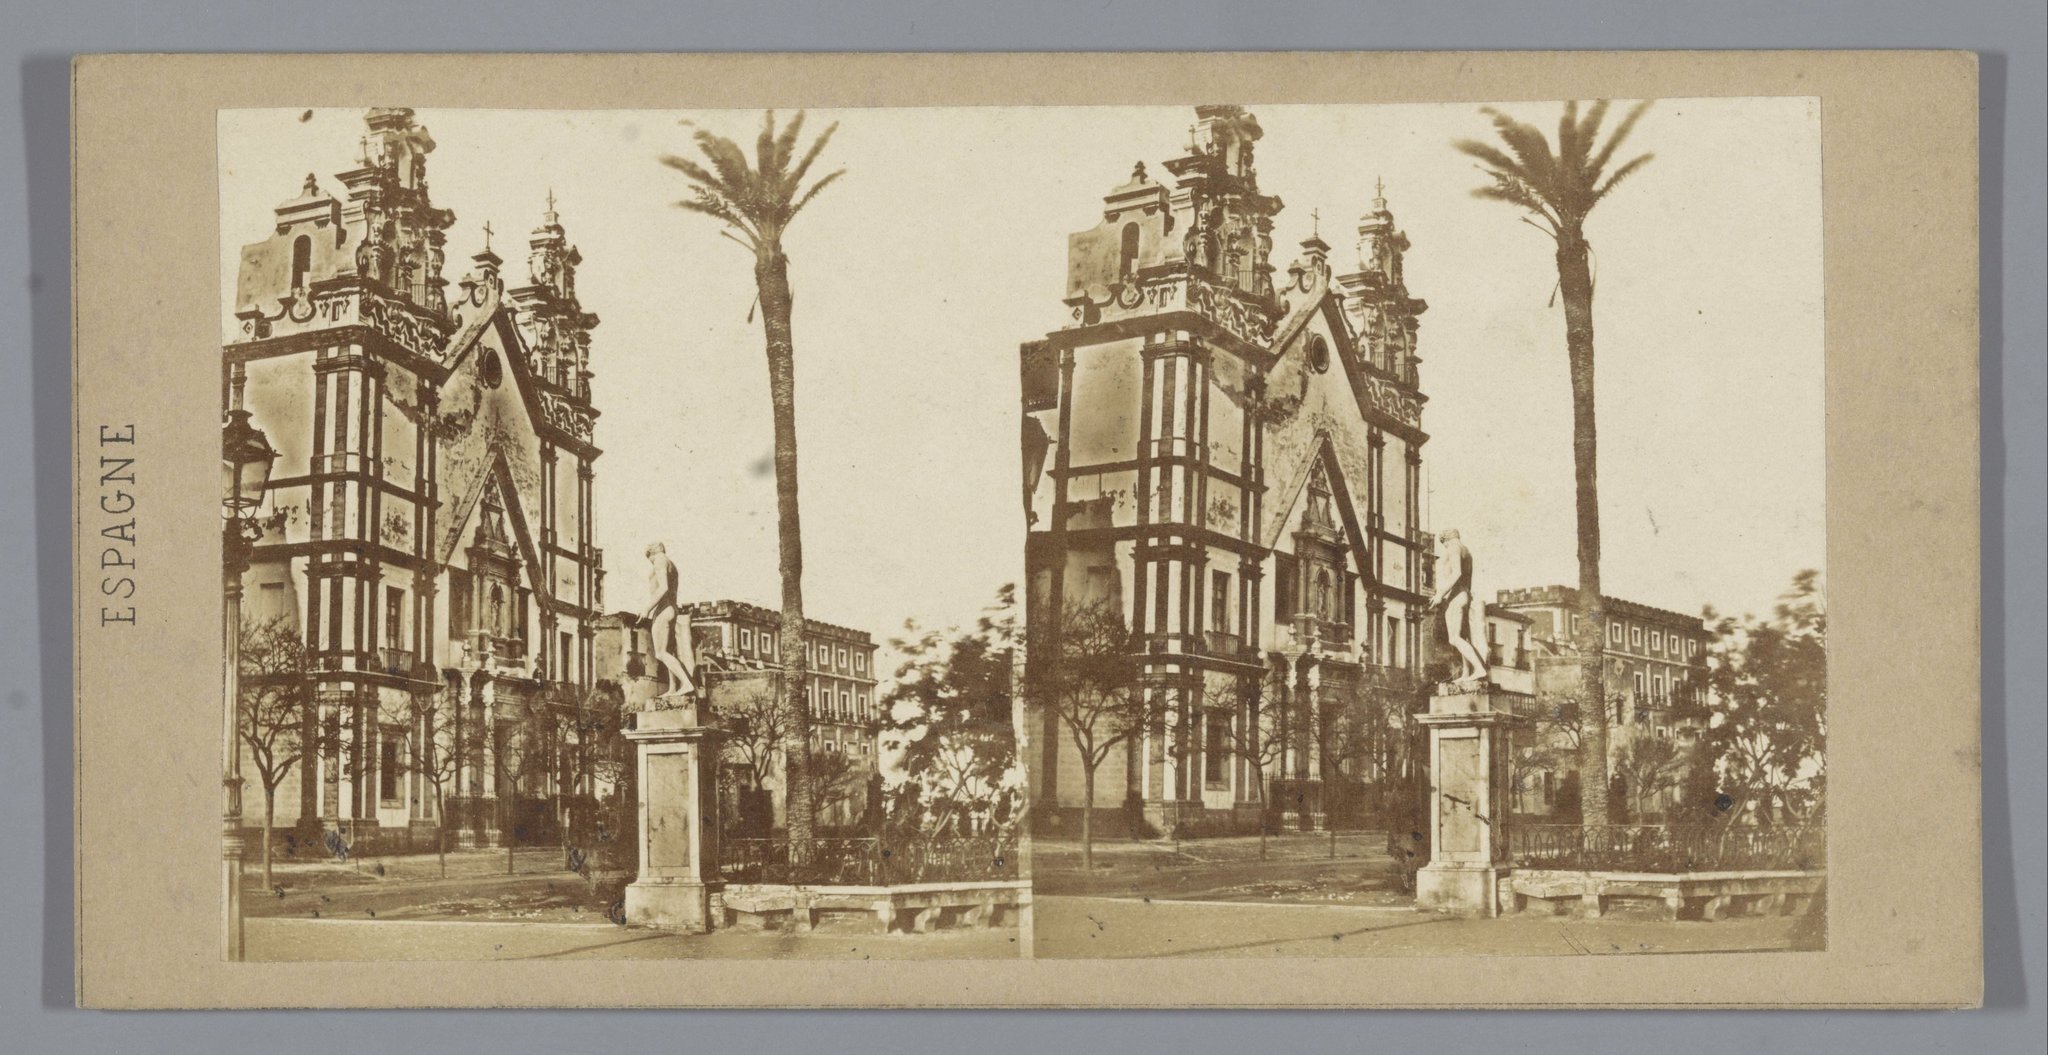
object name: stereograph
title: Alameda de Apodaca, à Cadix.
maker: Anonymous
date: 1850-1880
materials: cardboard, photographic support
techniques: albumen print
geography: cádiz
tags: church (exterior), sculpture, façade (of house or building)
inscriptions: number: ‘No 363.’, inscription: ‘Espagne’